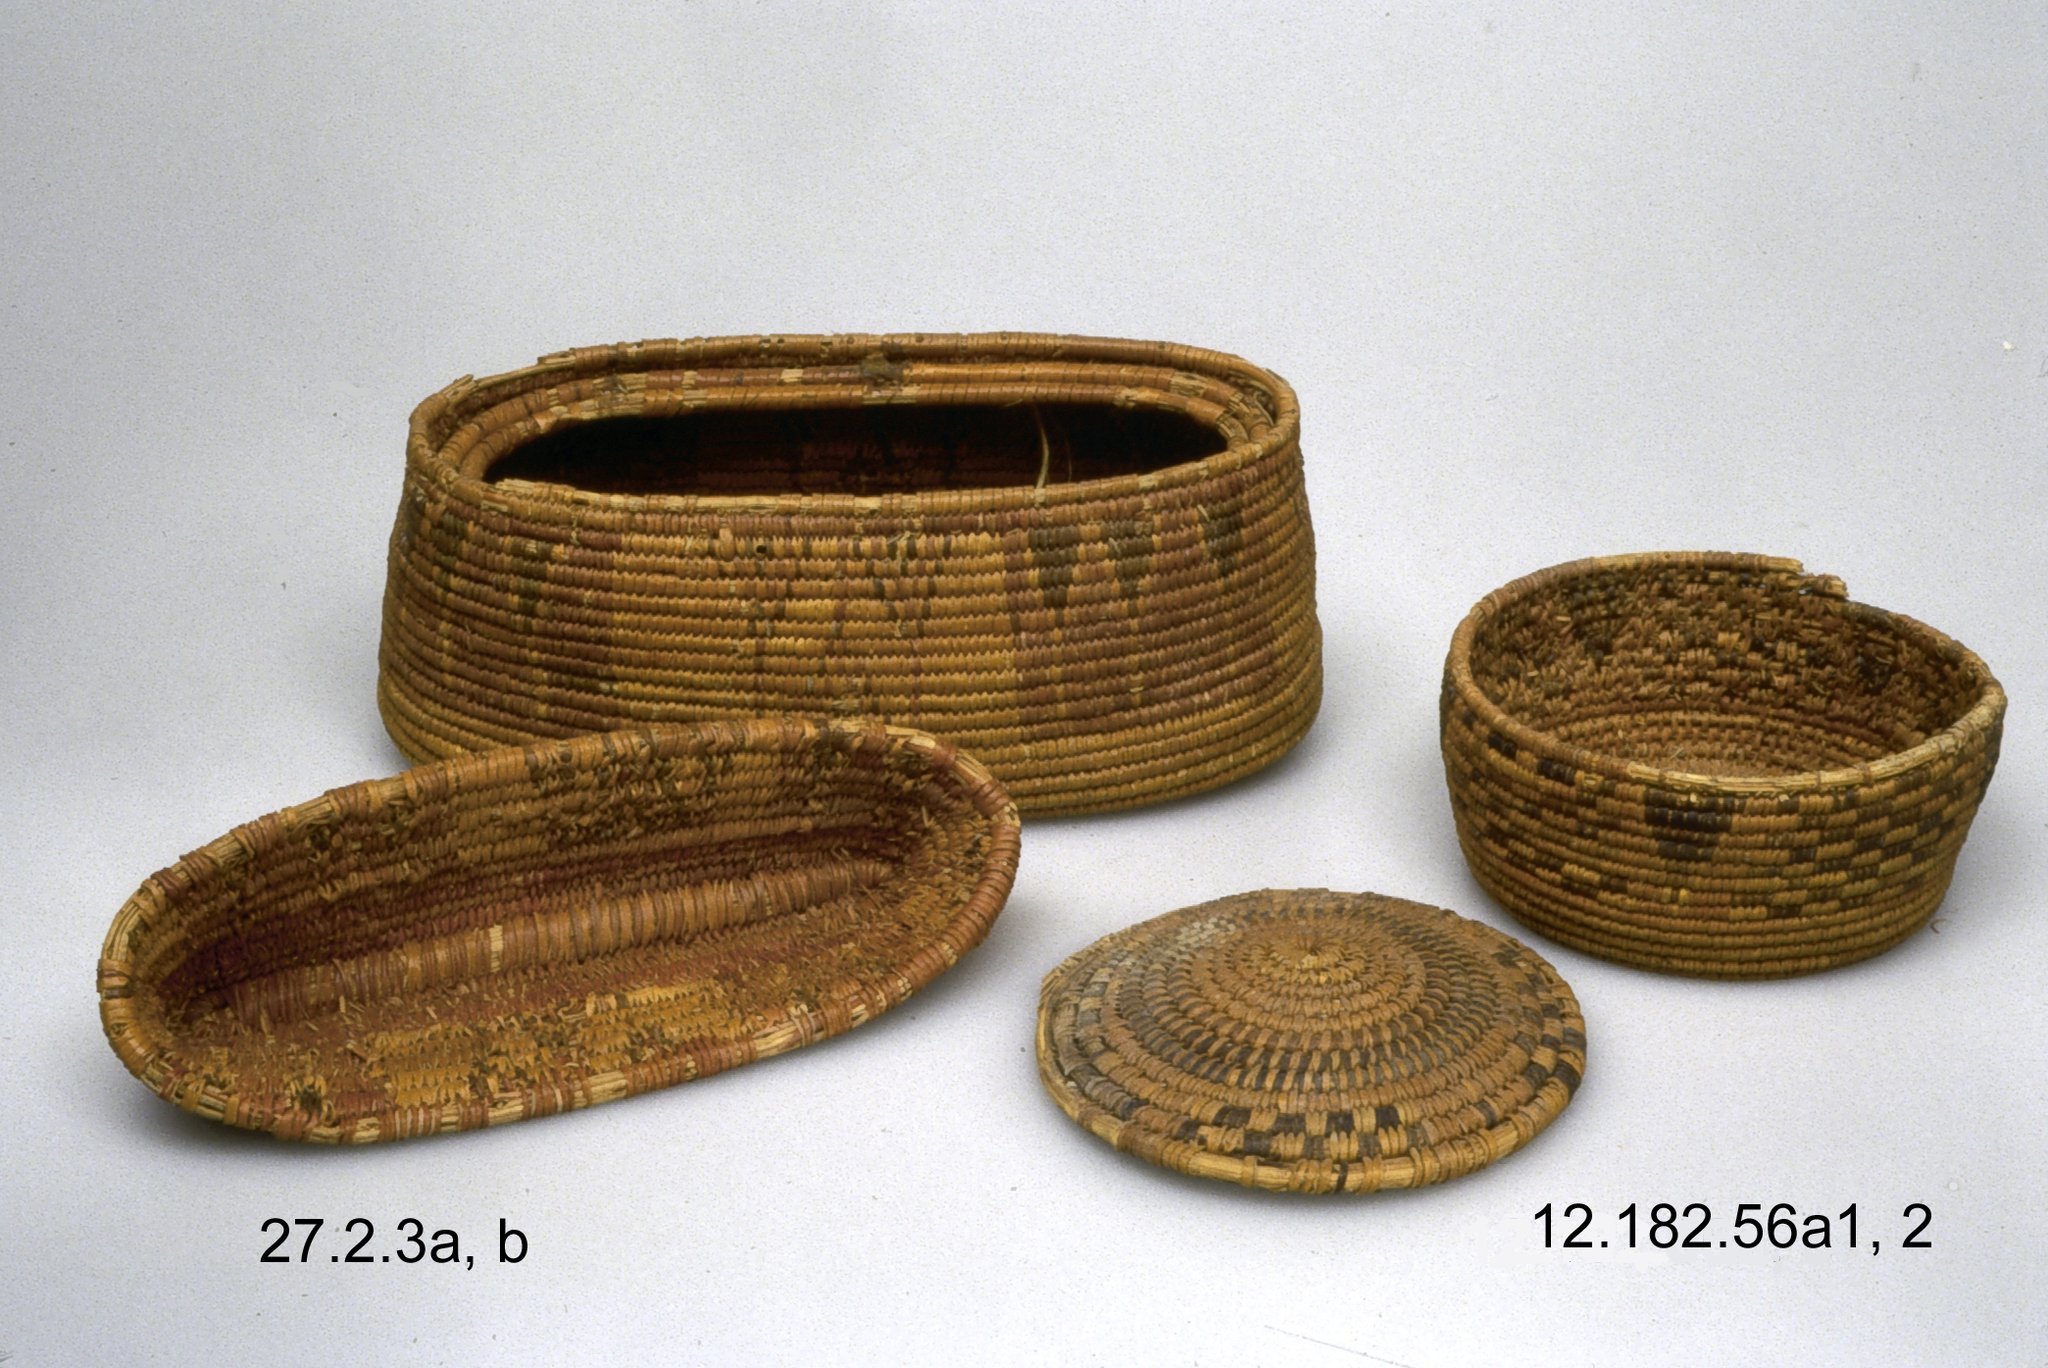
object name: basket, cylindrical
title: Cylindrical Basket and Lid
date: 1550-1295 BCE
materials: fiber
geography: southern upper egypt